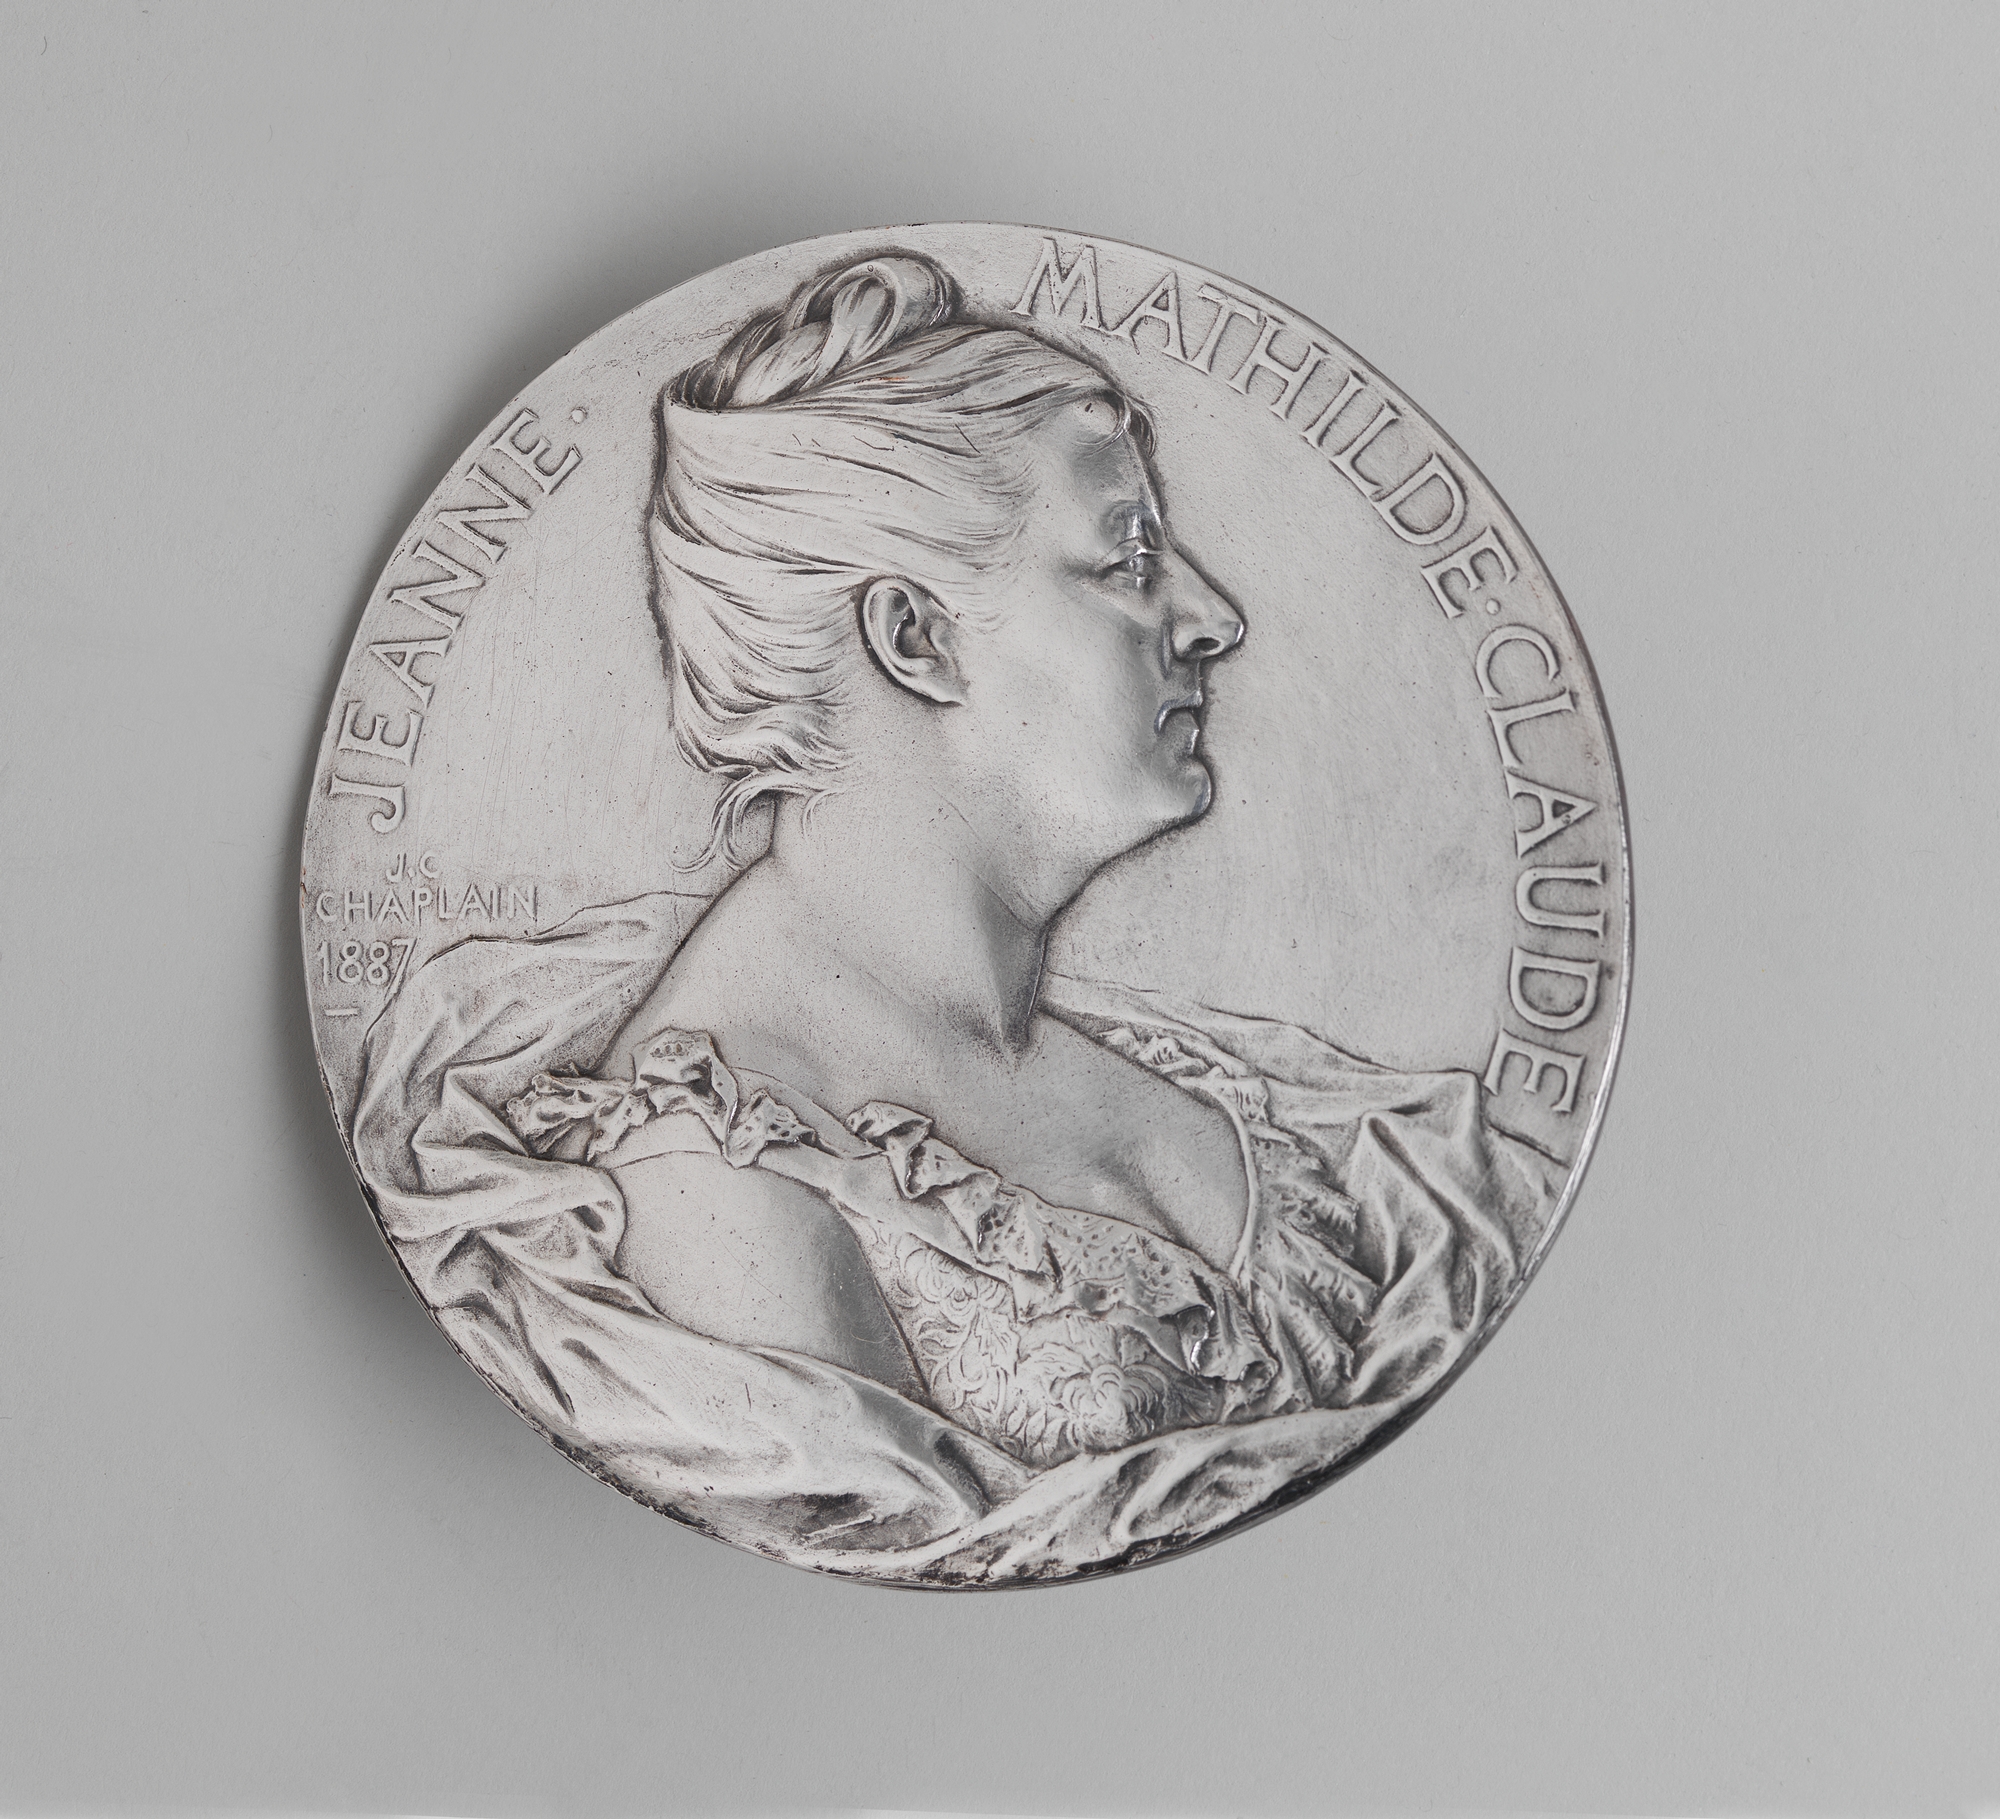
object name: medallion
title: Mme Jeanne Mathilde Claude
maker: jules-clément chaplain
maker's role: artist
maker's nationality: french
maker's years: 1839-1909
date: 1887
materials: copper, silver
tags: profiles,women